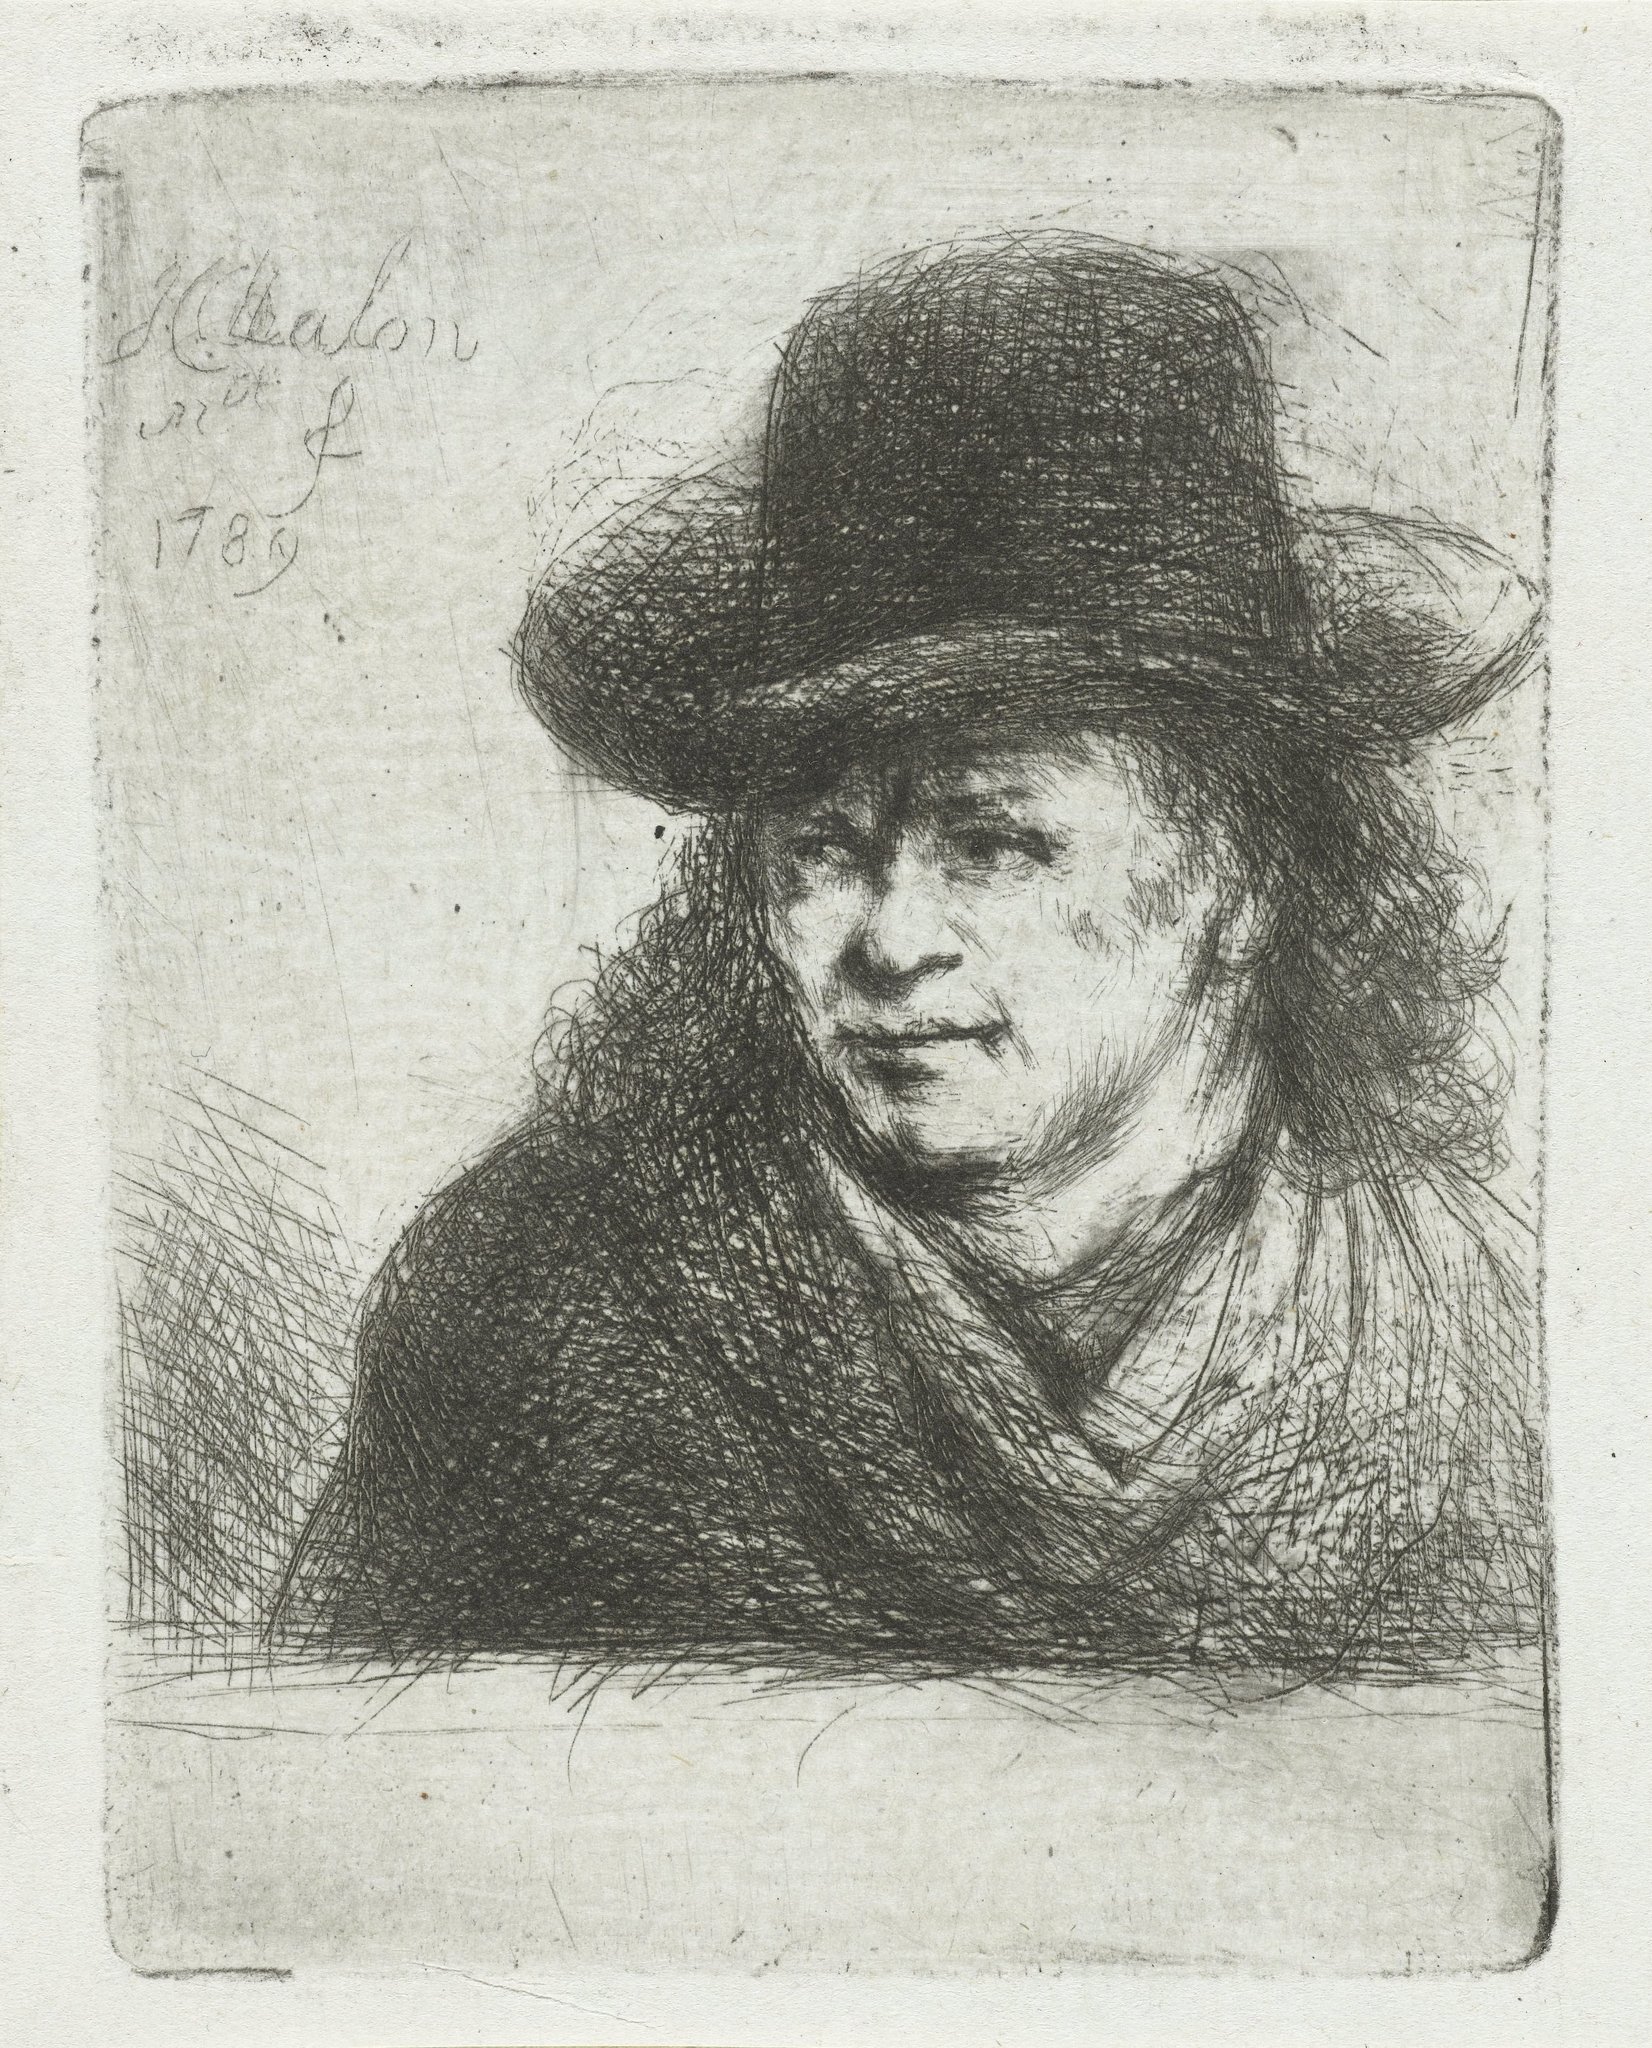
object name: print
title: Man met hoed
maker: jan chalon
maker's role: print maker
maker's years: 1738-1795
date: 1789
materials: paper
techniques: drypoint, etching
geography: northern netherlands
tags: head-gear: hat (+ men's clothes), morphology of human expression (+ adult male (human being))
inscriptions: collector's mark: Lugt 924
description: Een volwassen man met hoed. Buste naar links.